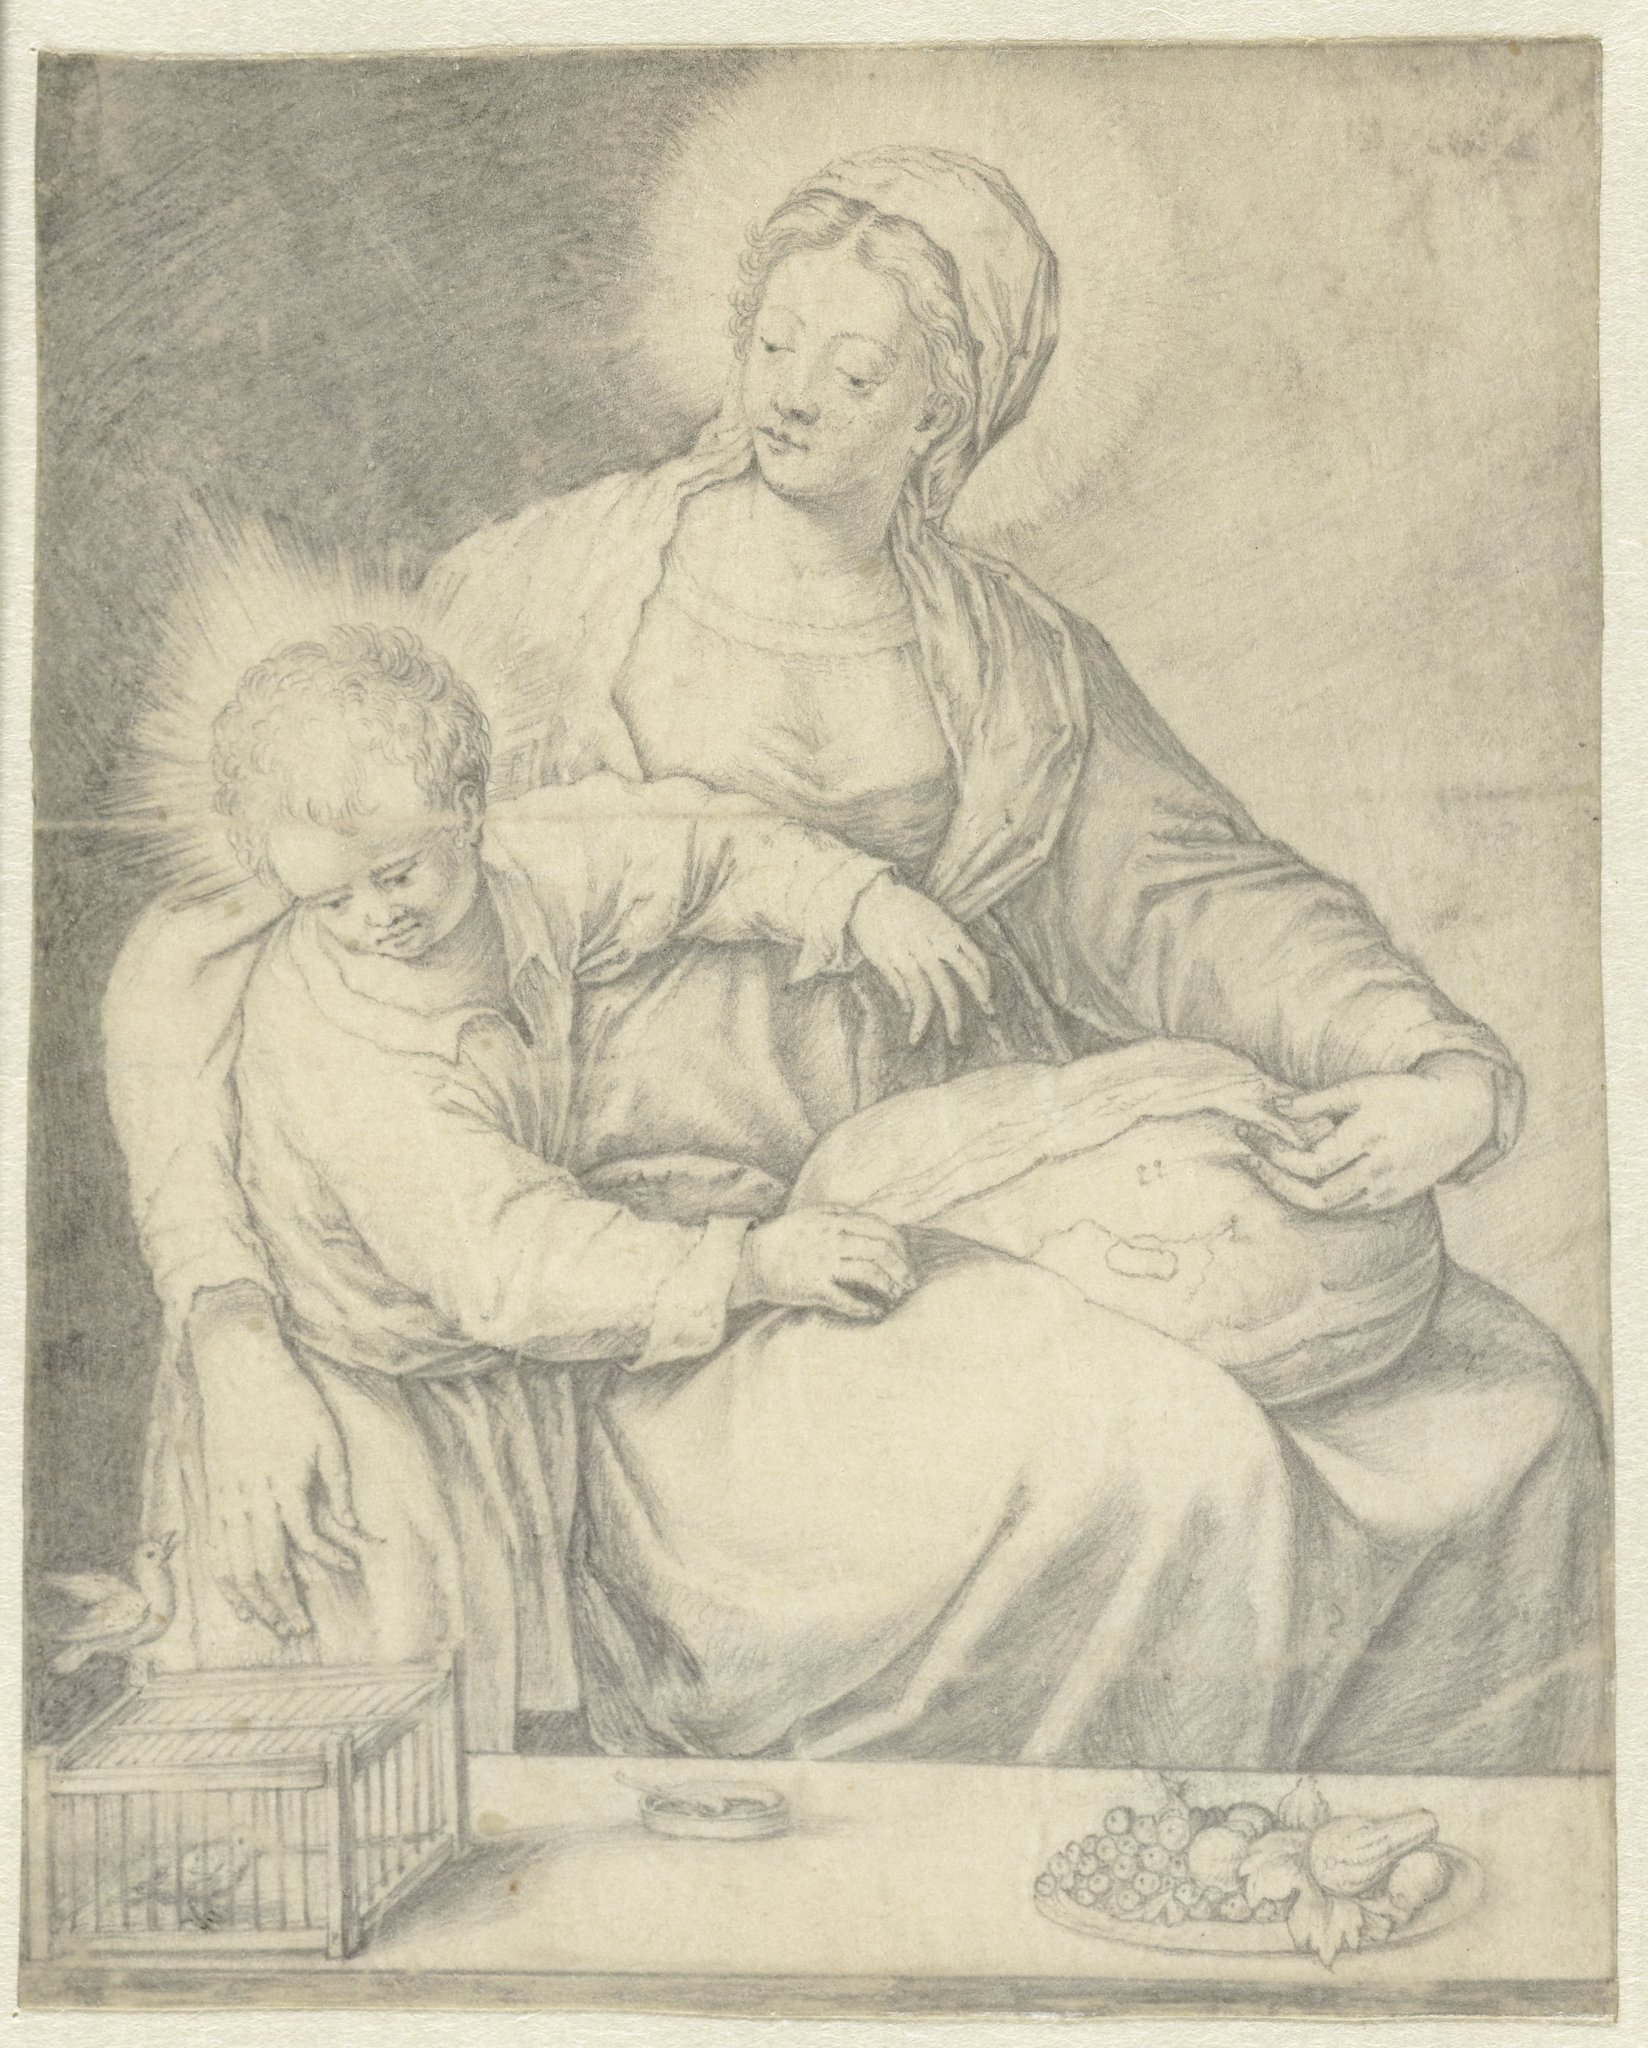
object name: drawing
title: De Heilige Maagd met het kind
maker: willem van mieris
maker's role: draughtsman, painter, print maker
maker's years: 1662-1747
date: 1672-1747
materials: parchment, pencil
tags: mary sitting or enthroned, the christ-child in front of her, standing in her lap (or in front of her bosom), mary (standing) with the christ-child beside her (free-standing or leaning against her), specific aspects of christ-child ~ madonna-representations (n.b. secondary notation only), bird in a cage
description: De Heilige Maagd met het kind bij een vogelkooitje en een schaal met vruchten.